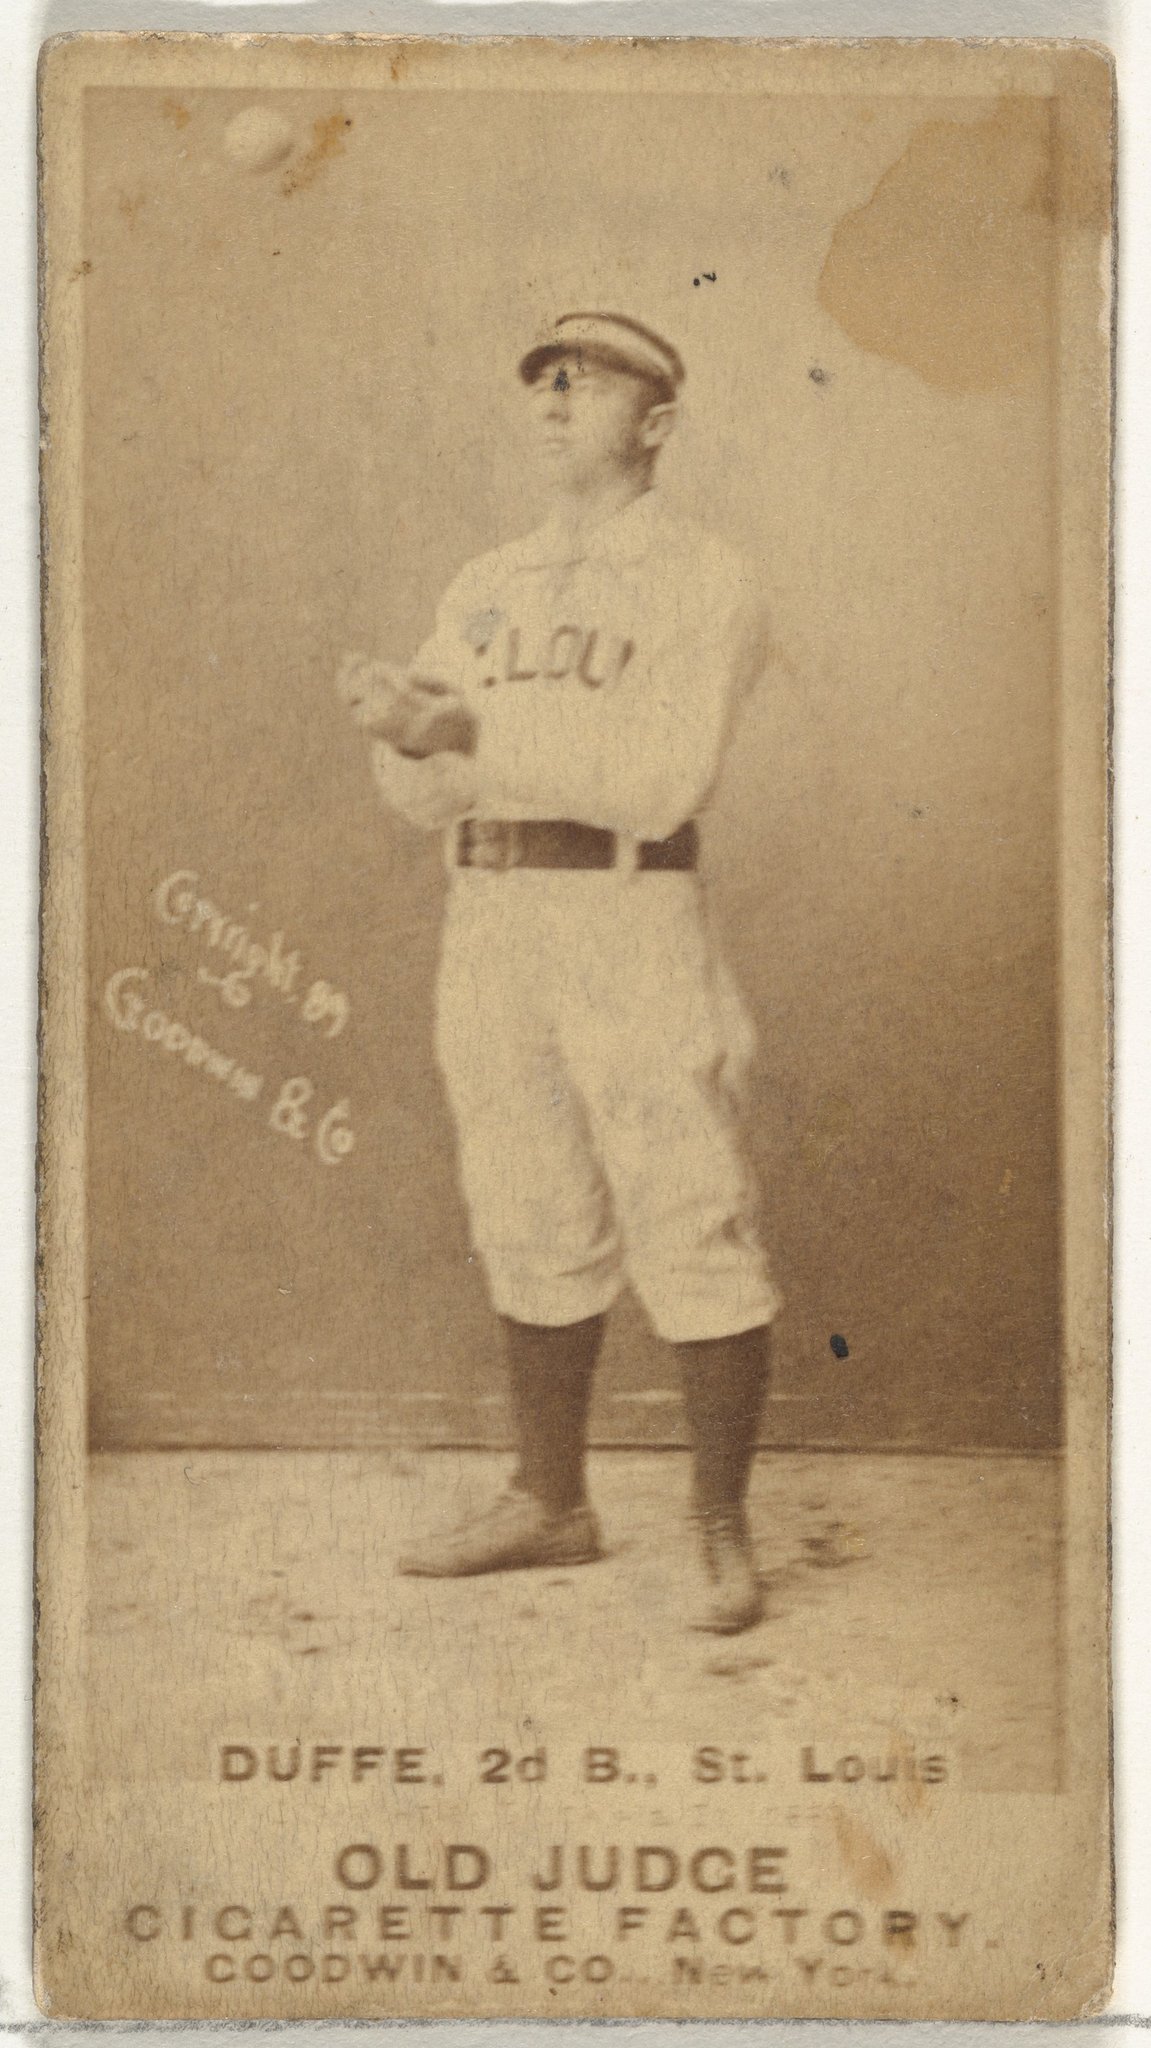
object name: baseball card, photograph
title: Charles Edward "Charlie" Duffee, 2nd Base, St. Louis Browns, from the Old Judge series (N172) for Old Judge Cigarettes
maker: goodwin & company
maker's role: publisher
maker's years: 1850-1950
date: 1889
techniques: albumen silver print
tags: men,portraits,baseball,athletes